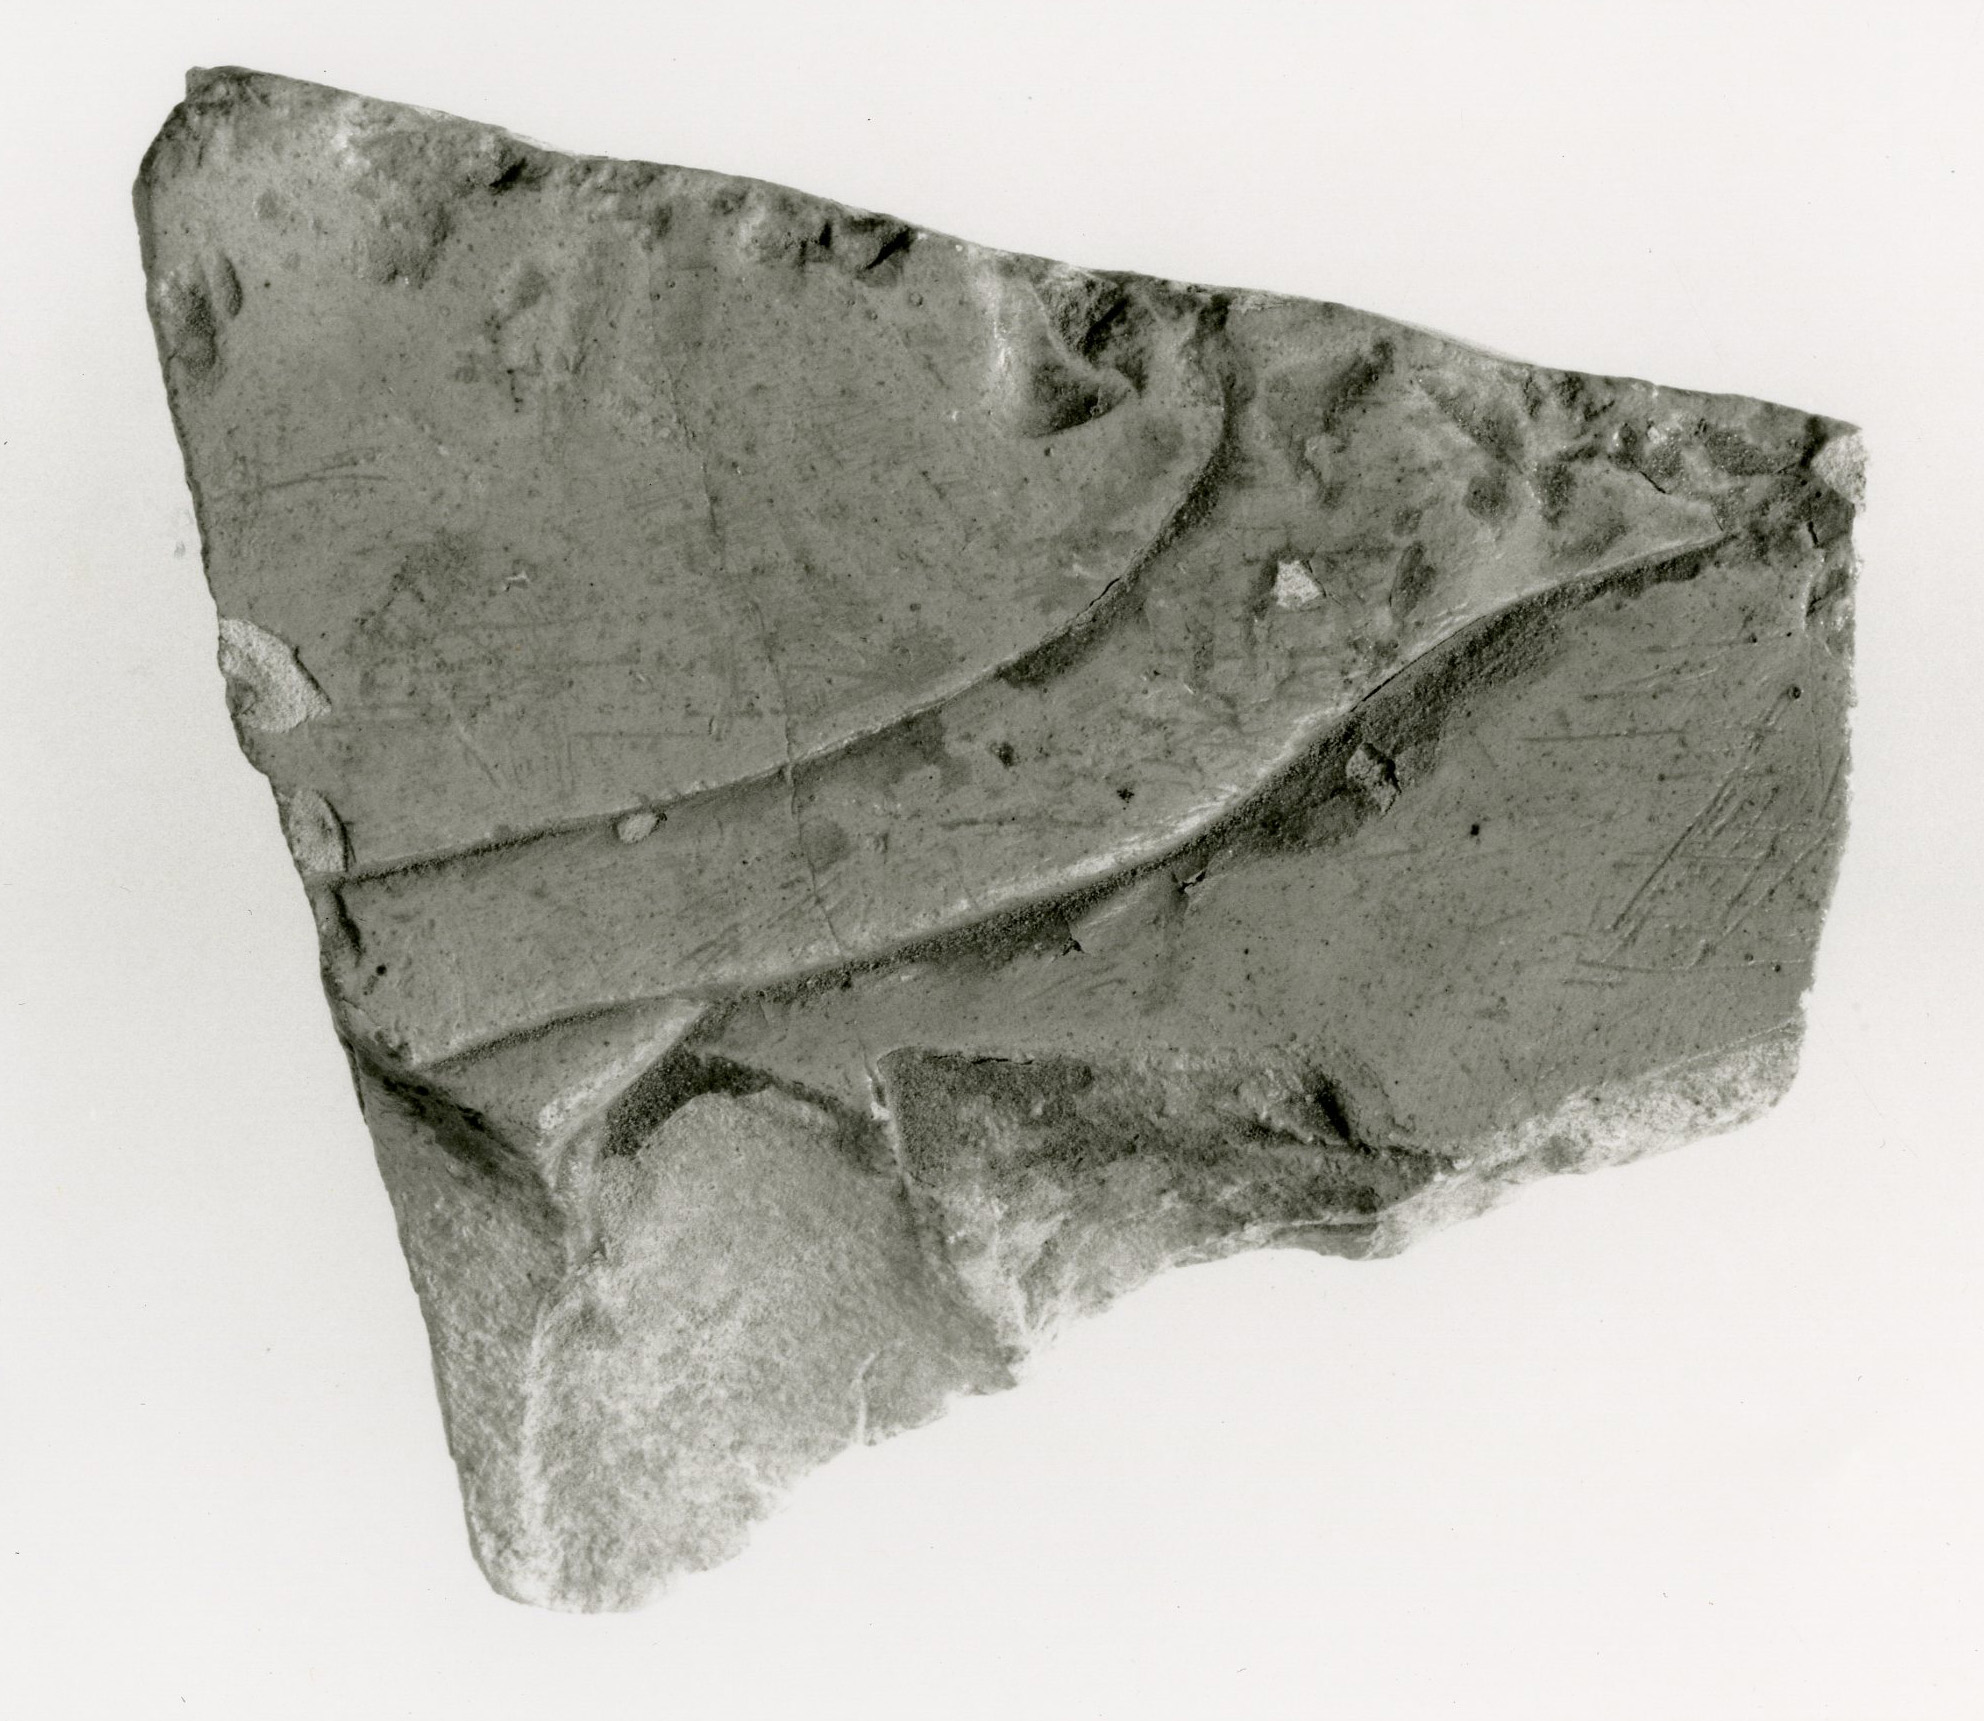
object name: relief, tomb of nespekashuty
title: Raised relief fragment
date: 664-610 BCE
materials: limestone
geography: egypt